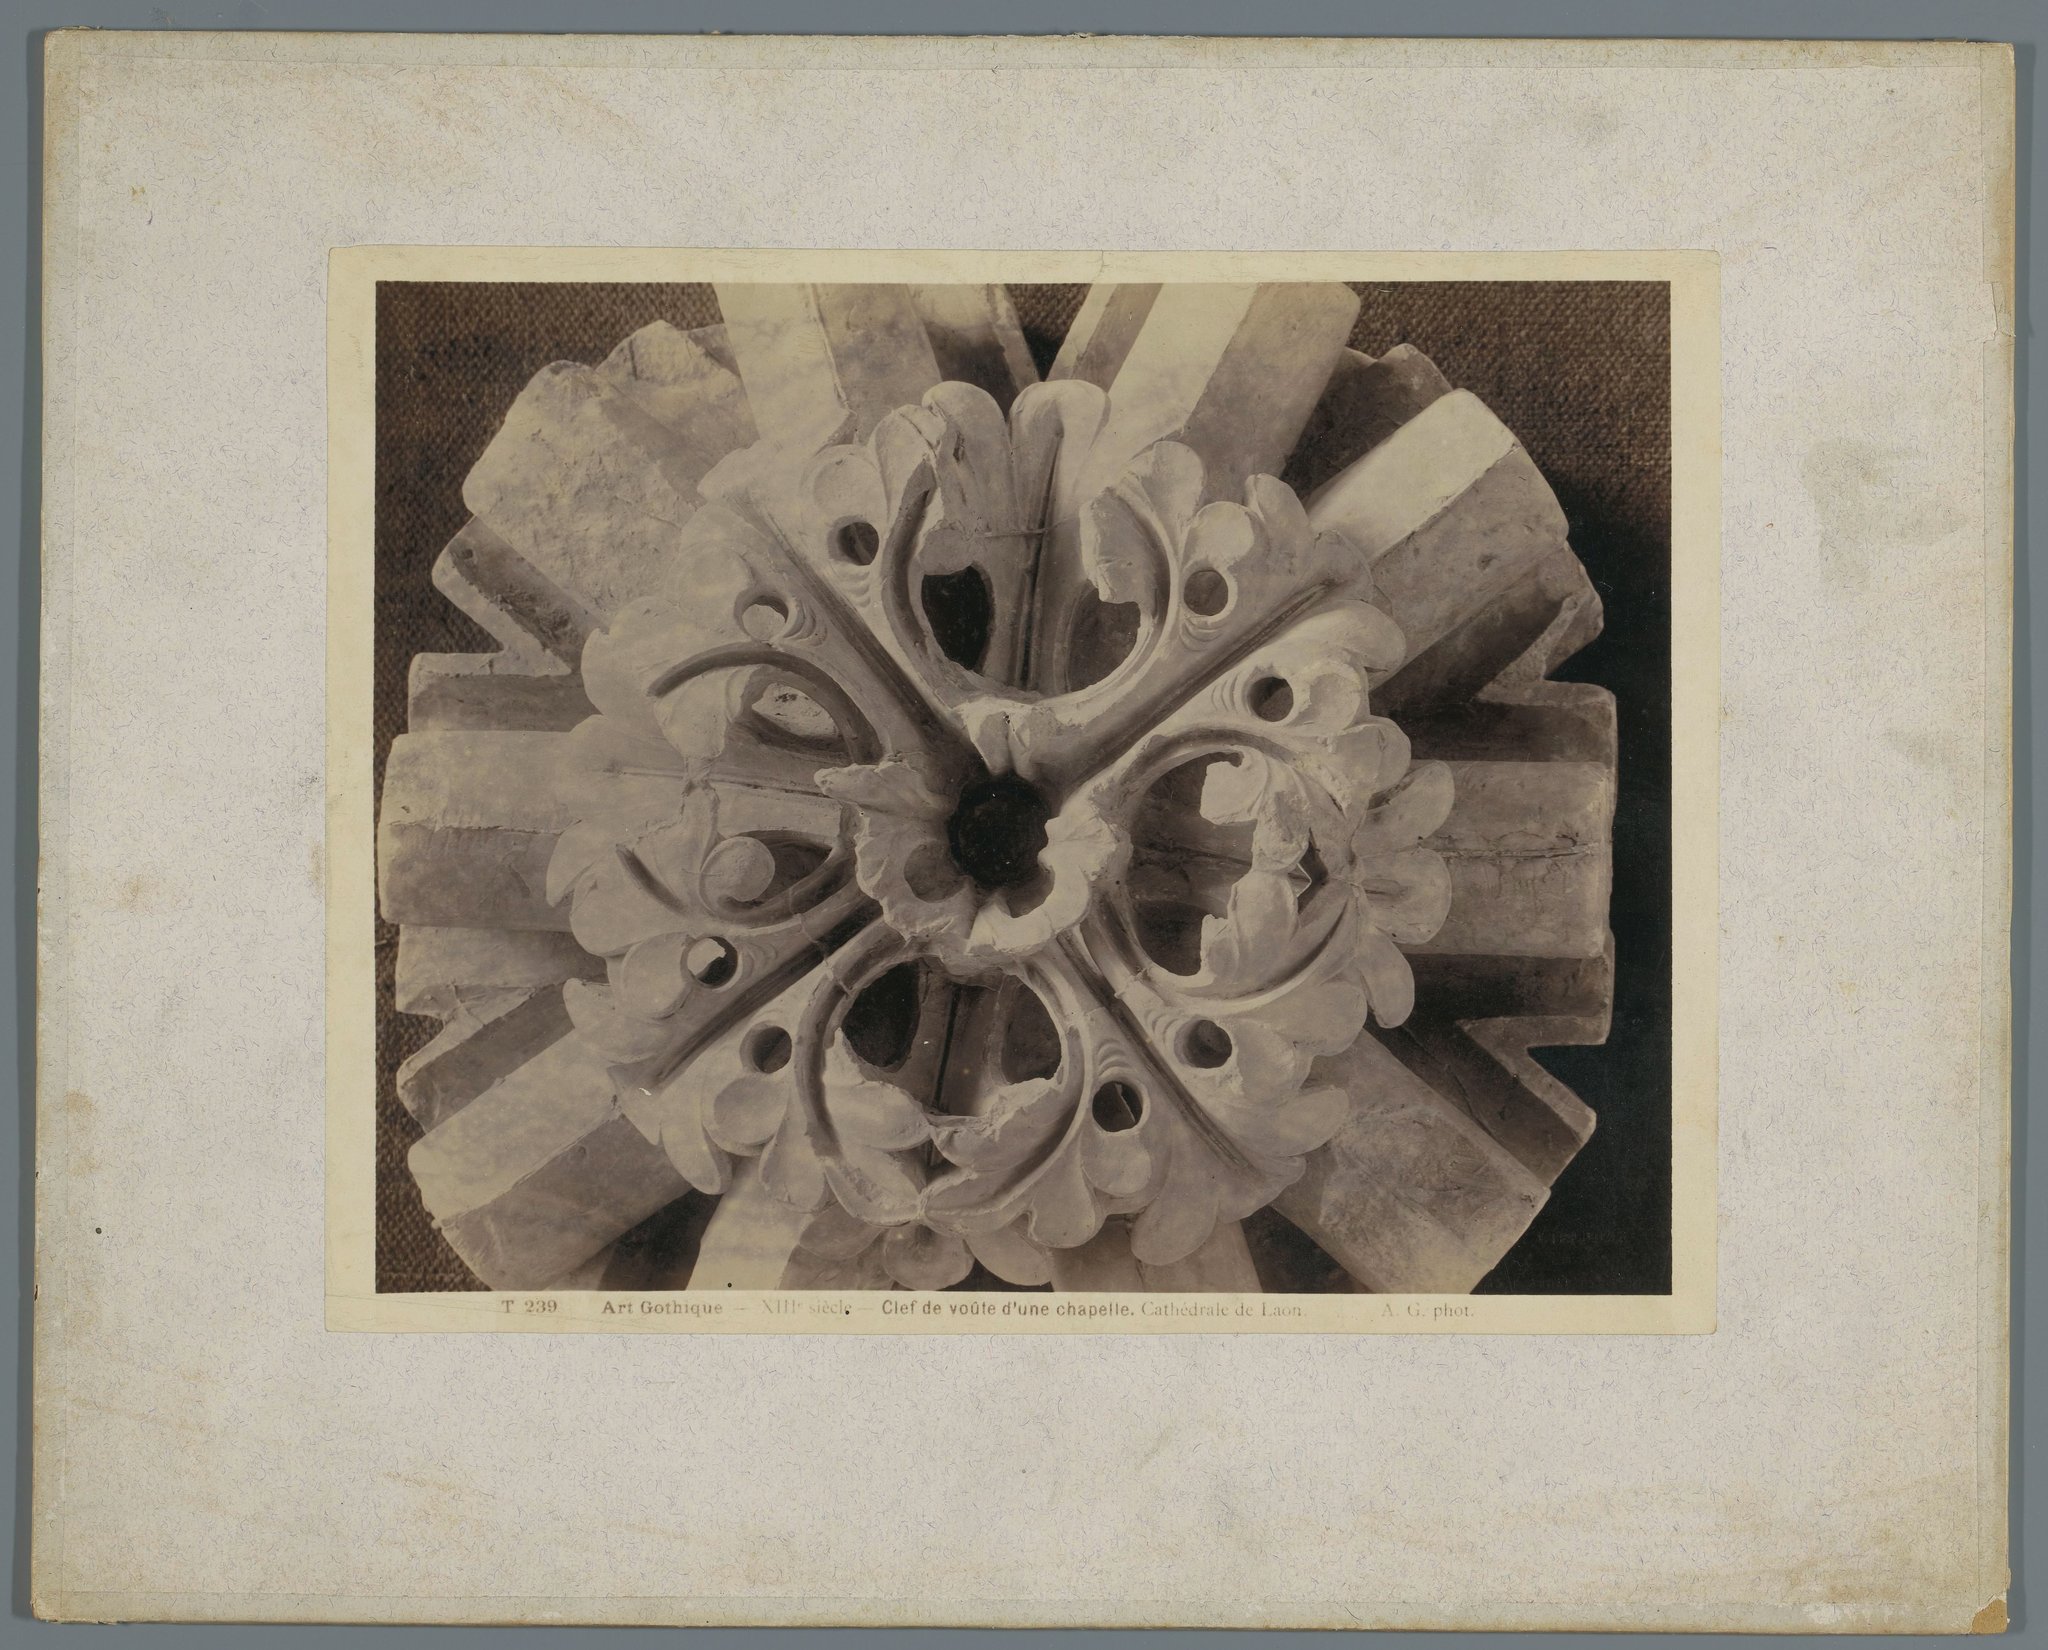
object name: photograph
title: Sluitsteen in de Kathedraal van Laon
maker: adolphe giraudon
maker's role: publisher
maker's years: 1849-1929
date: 1875-1900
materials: cardboard, photographic support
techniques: albumen print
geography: paris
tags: acanthus ~ ornament, sculpture (+ relief ~ sculpture)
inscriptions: number: ‘T 239’, name: ‘A. GIRAUDON ÉDITEUR 15, R. BONAPARTE, PARIS’, collector's mark: ‘RIJKS-NORMAALSCHOOL voor TEEKENONDERWIJZERS AMSTERDAM’